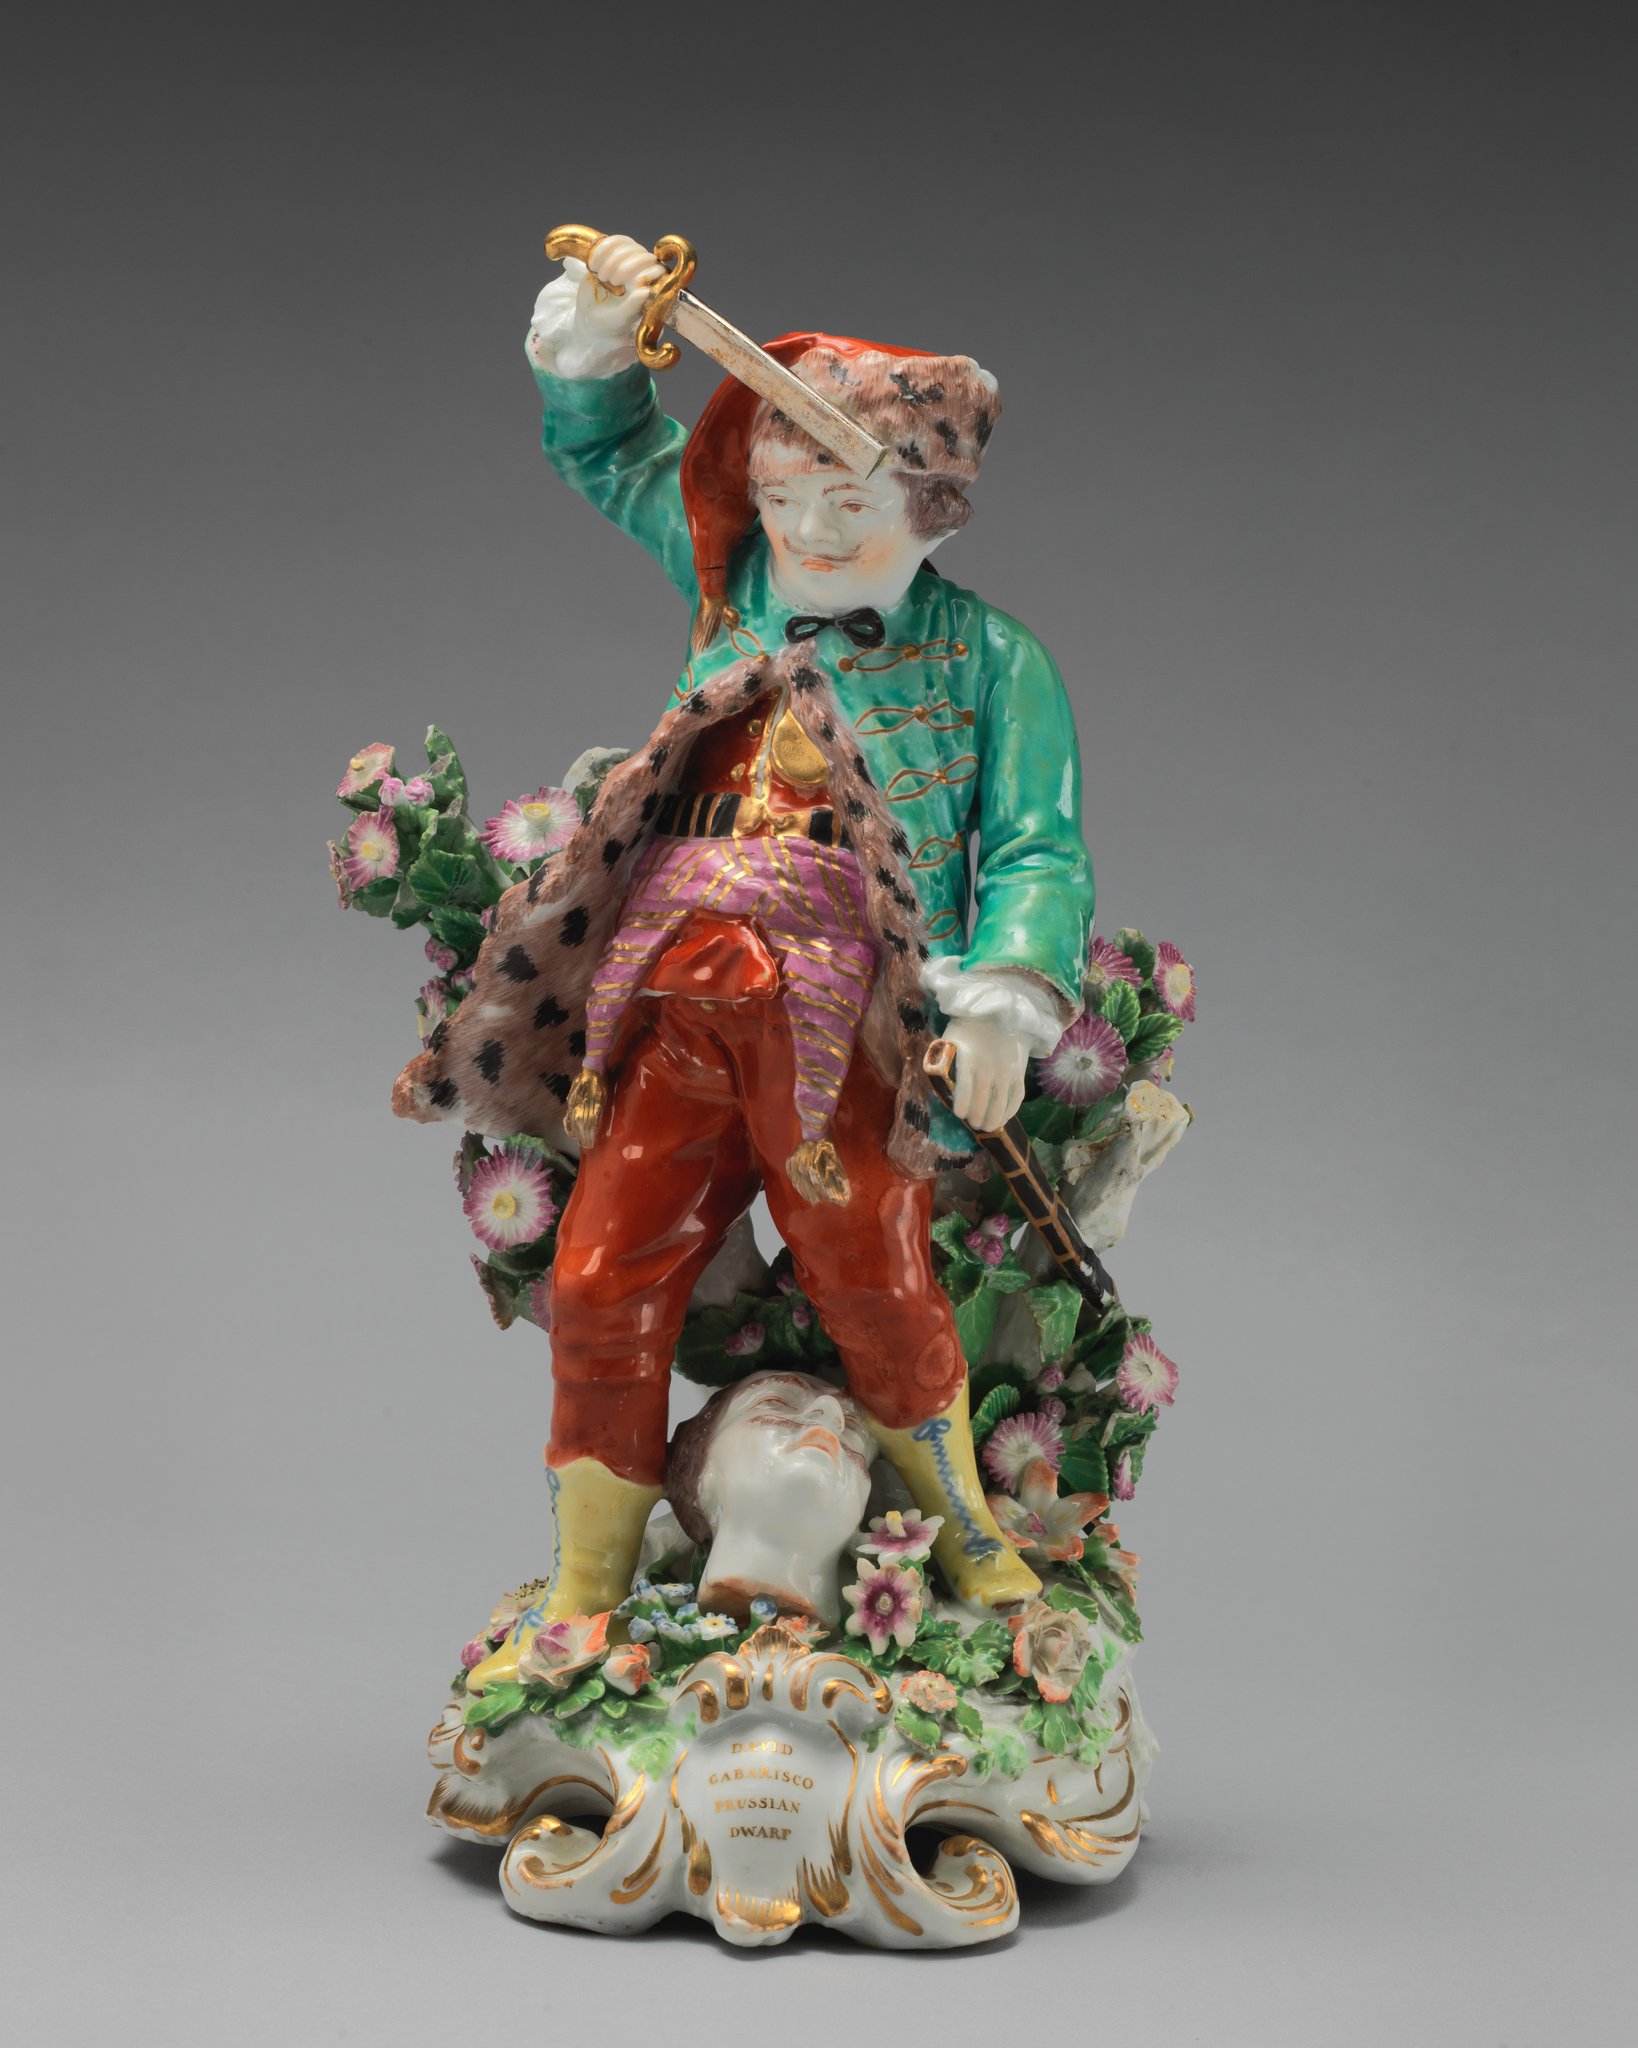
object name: figure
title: David Gabarisco, a Prussian dwarf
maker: chelsea porcelain manufactory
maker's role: factory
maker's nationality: british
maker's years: 1744-1784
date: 1761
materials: soft paste porcelain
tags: swords,heads,men,flowers